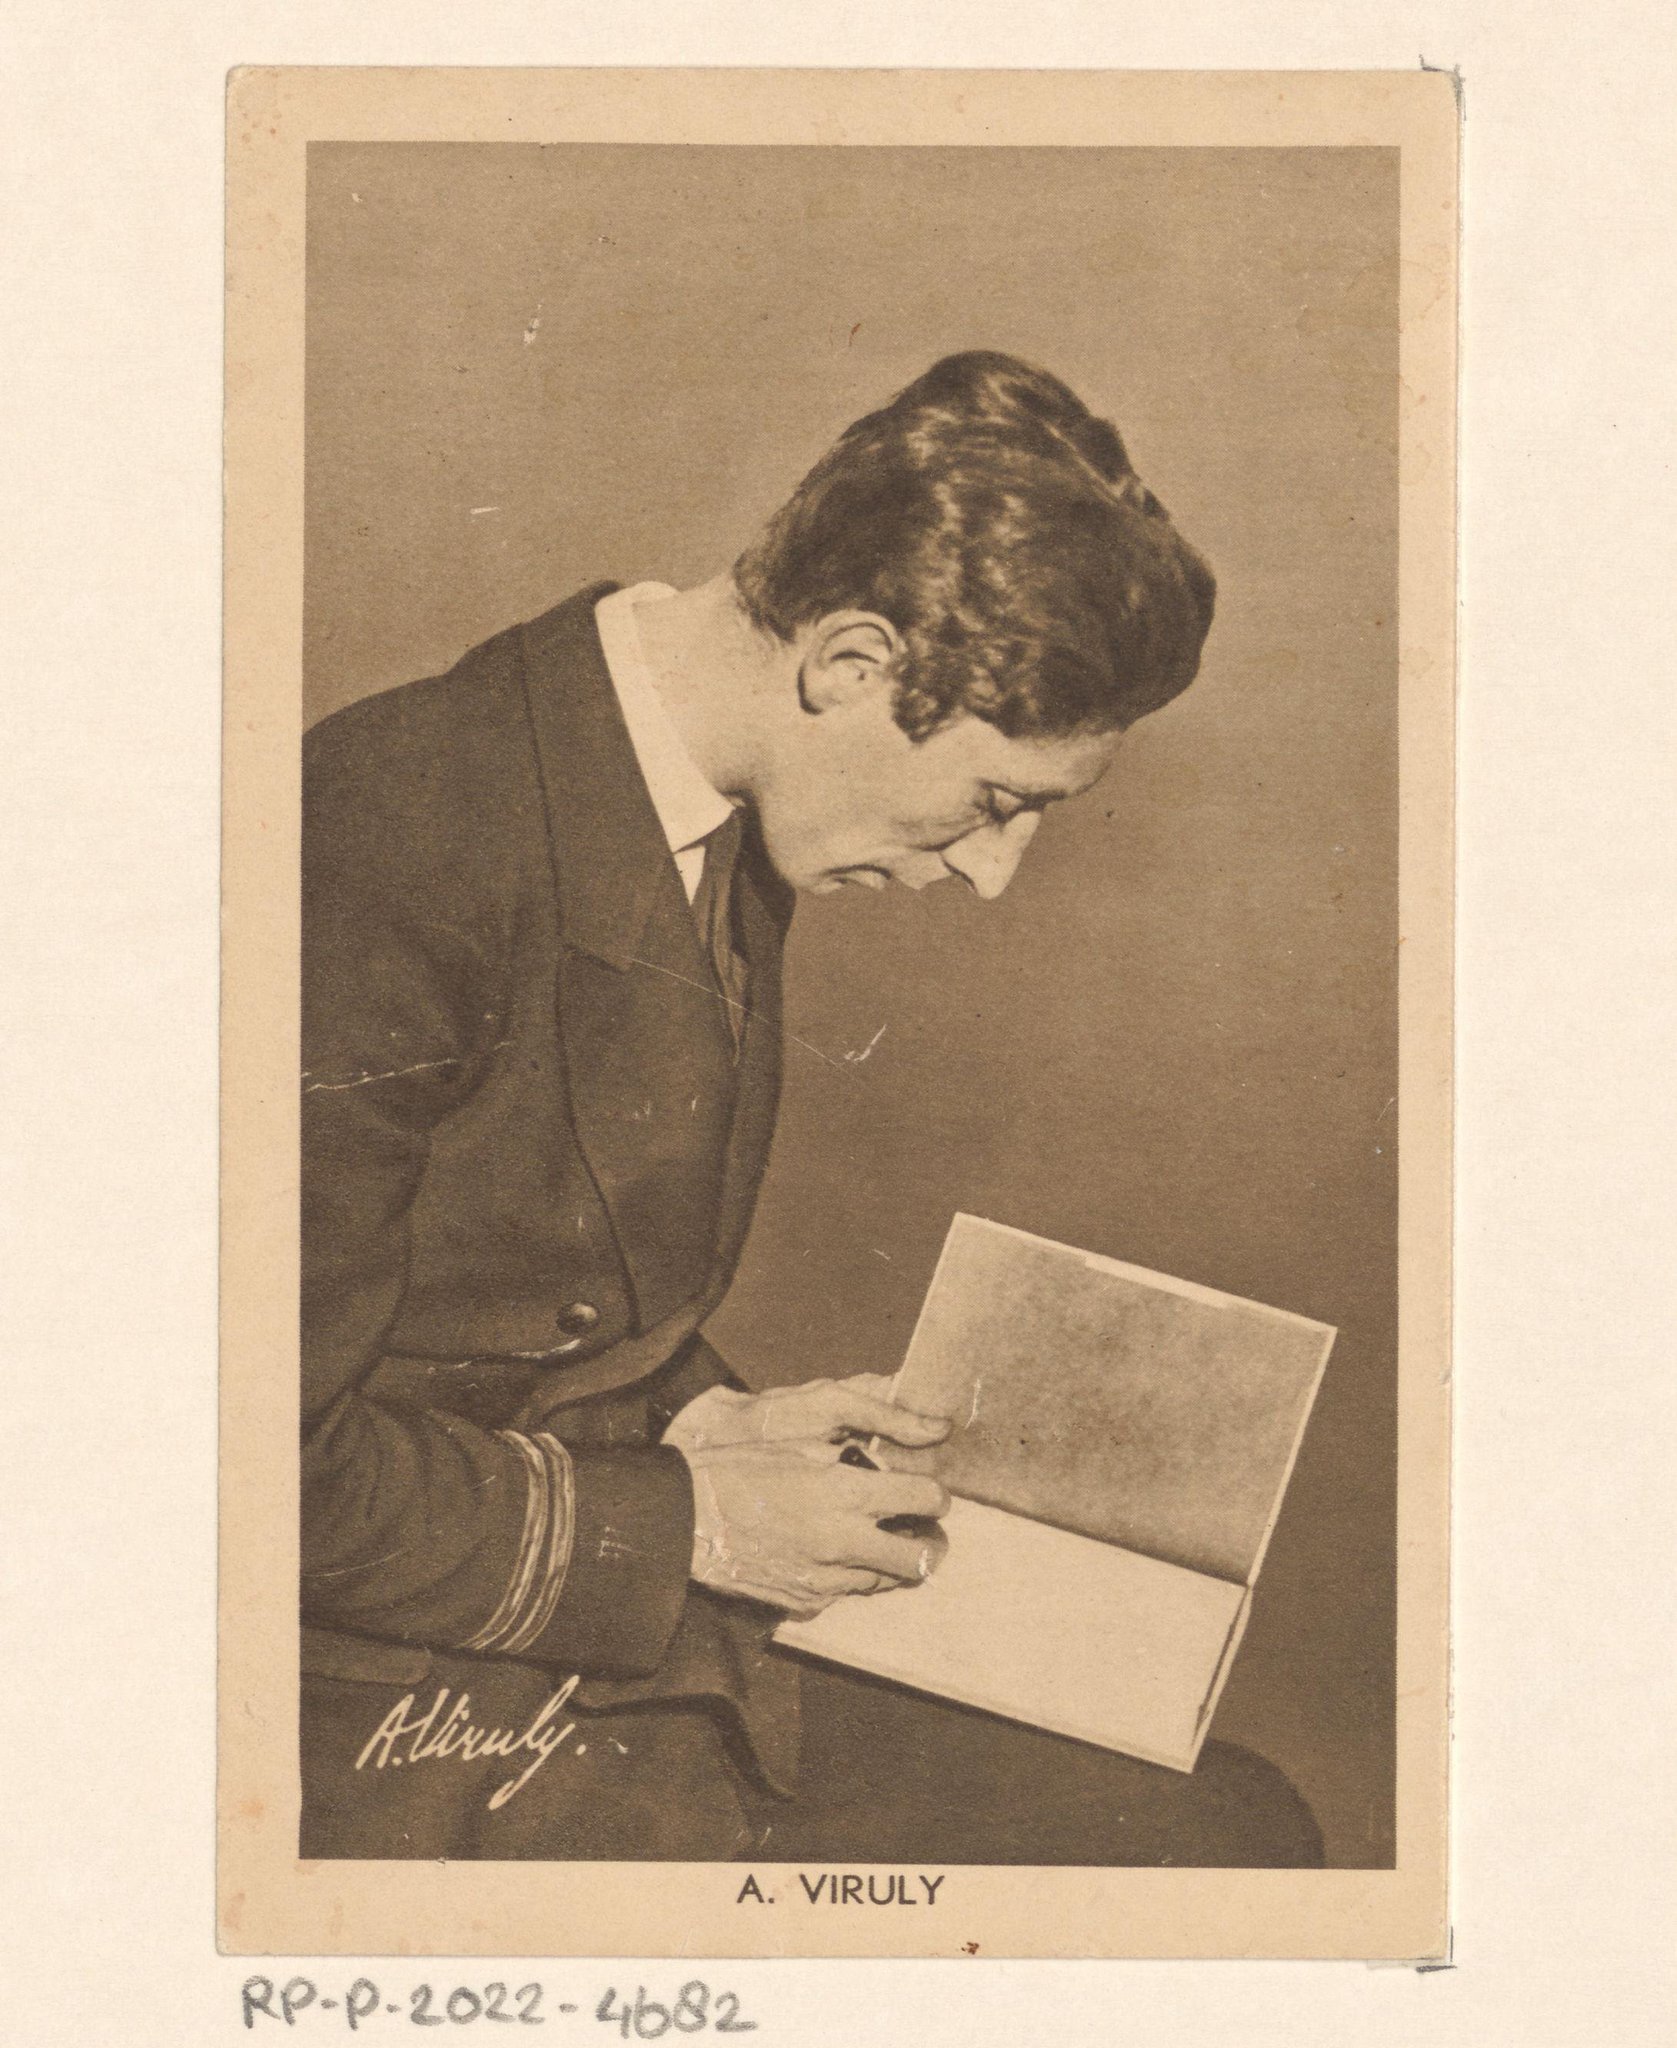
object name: ansichtkaart, prentbriefkaart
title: Portret van Adriaan Viruly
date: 1933-1941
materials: paper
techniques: rotogravure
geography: amsterdam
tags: historical persons, portrait of a writer